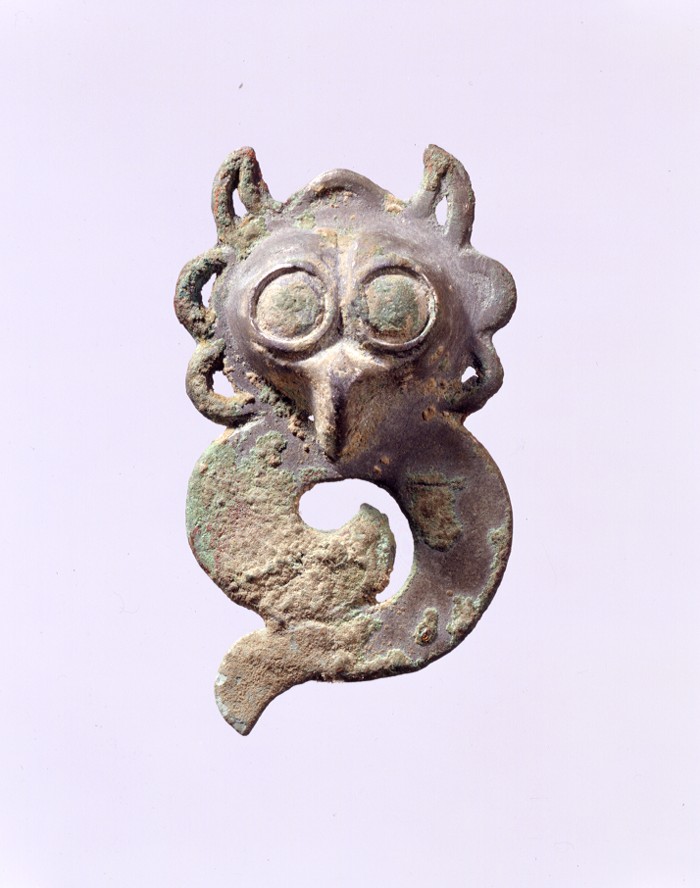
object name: harness ornament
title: Harness Ornament with Owl's Head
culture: northwest chinese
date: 400-301 BCE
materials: bronze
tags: owls